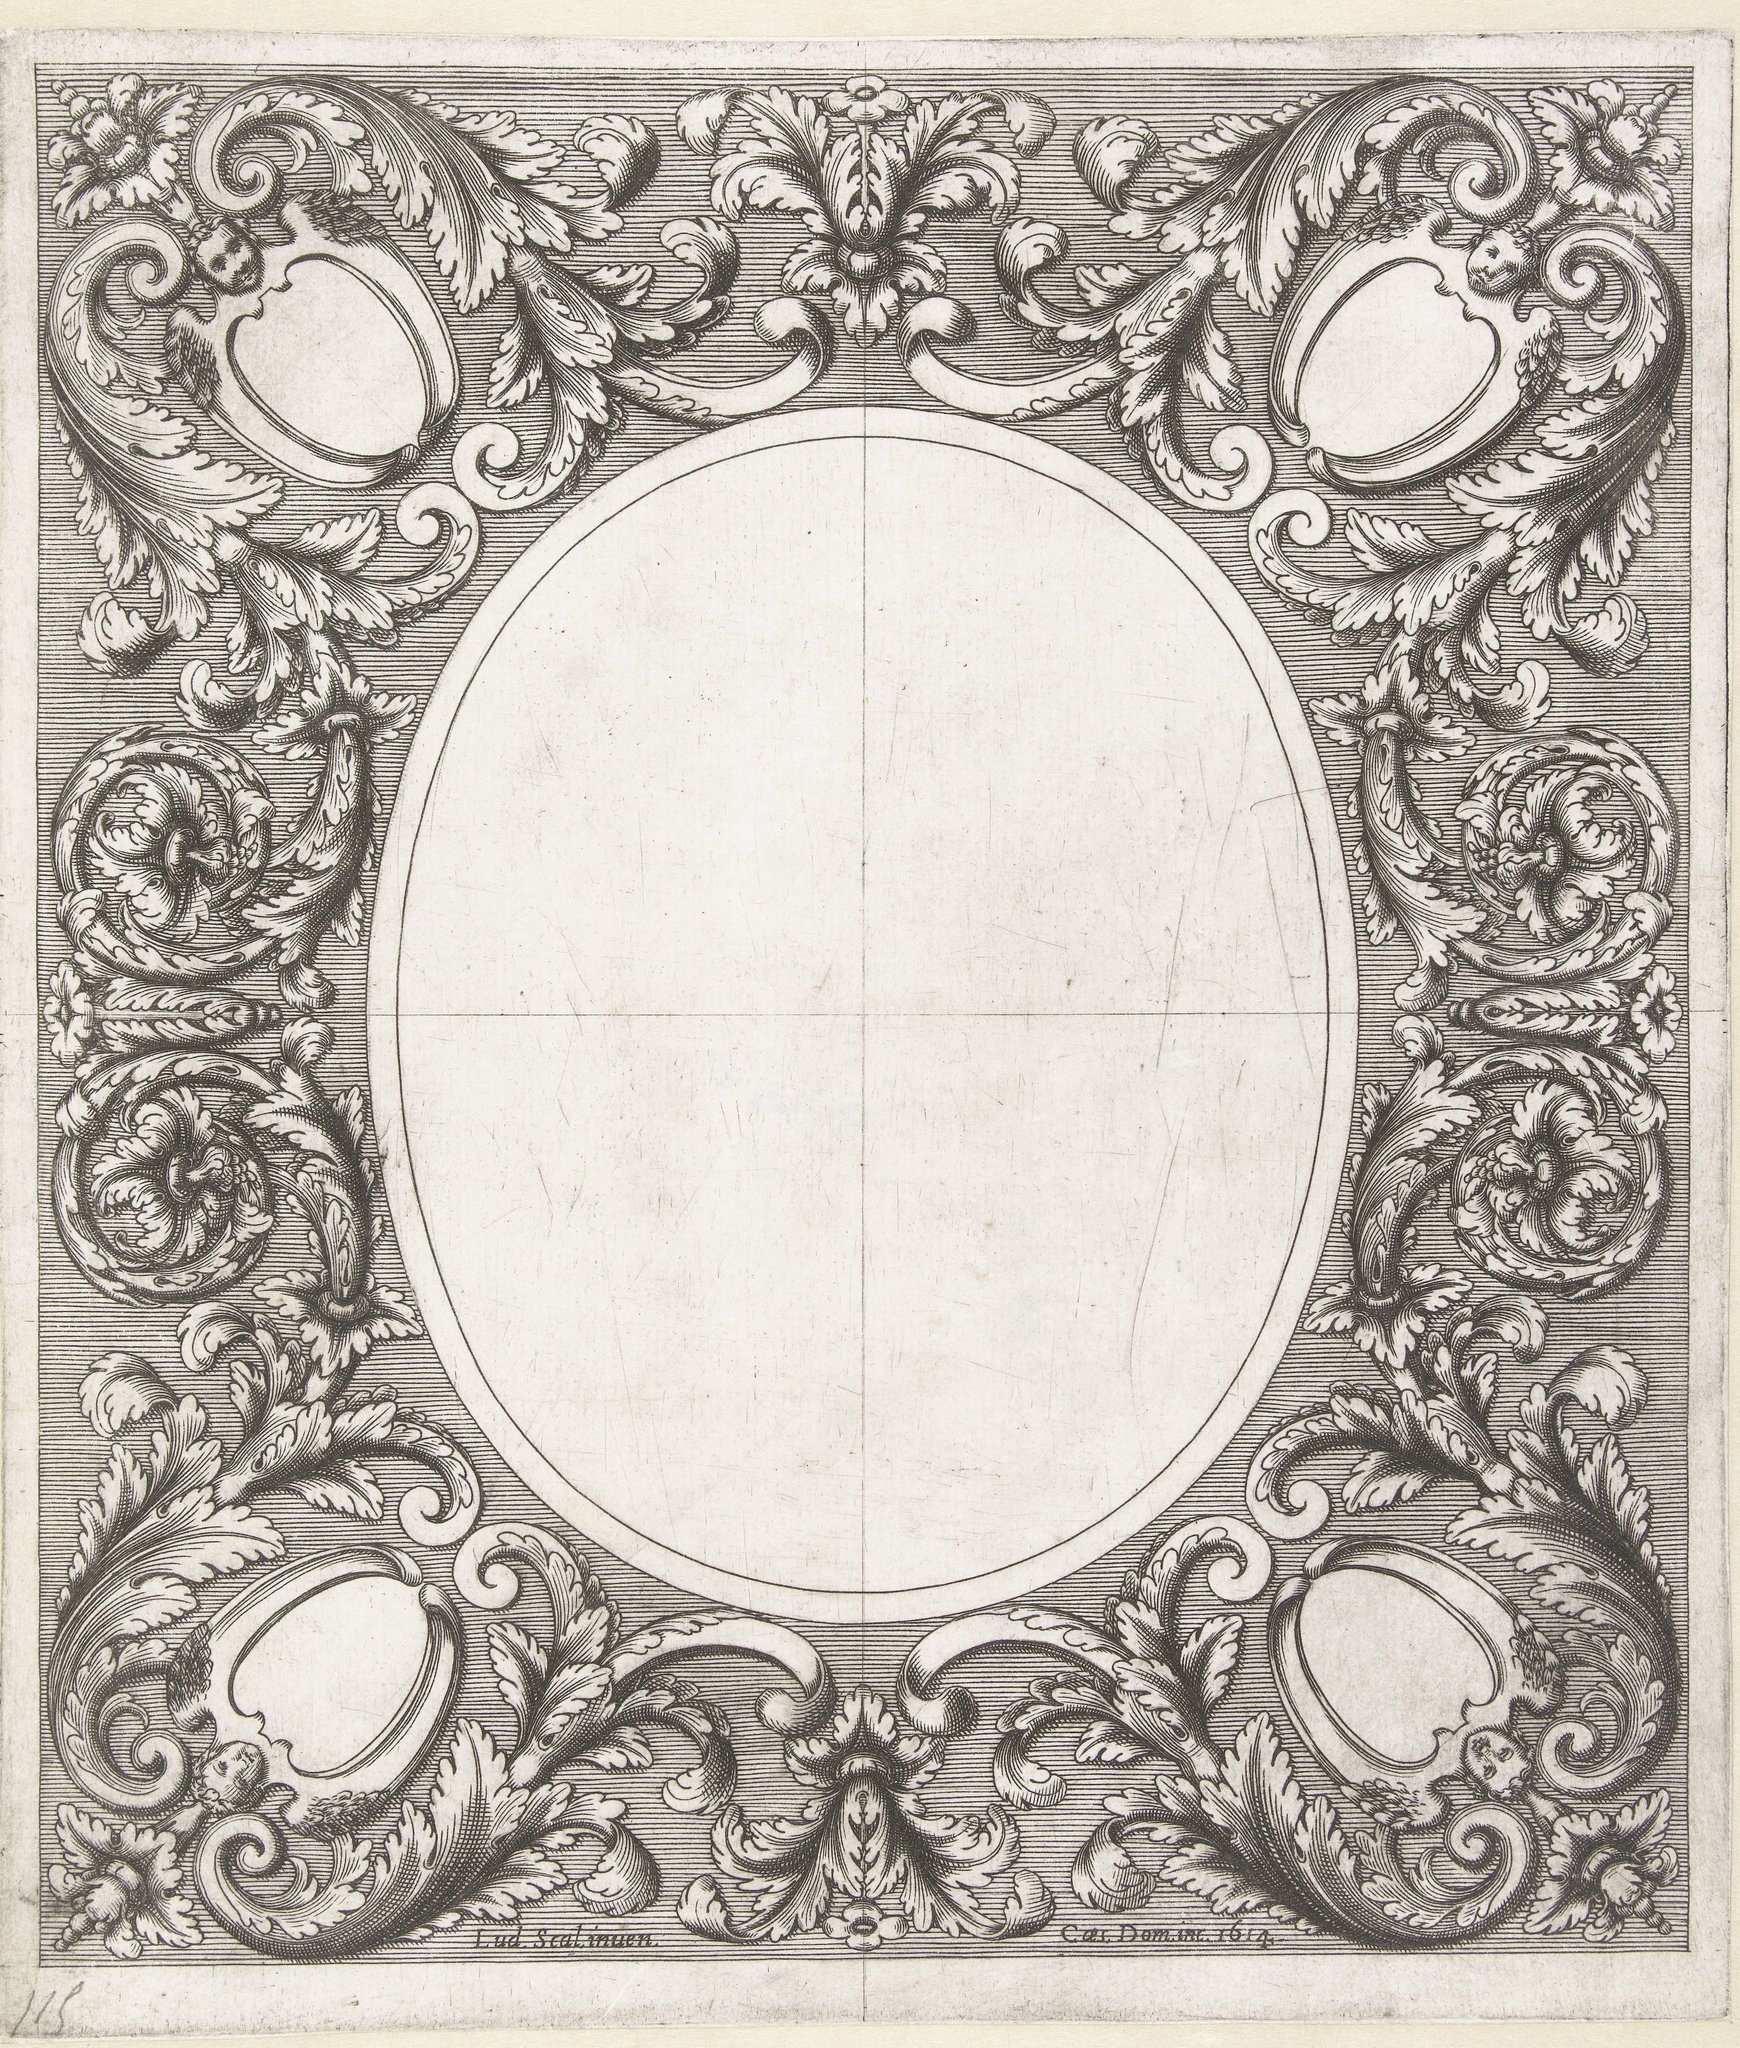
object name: print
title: Plafonddecoratie met in het midden een leeg ovaal veld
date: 1614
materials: paper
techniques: engraving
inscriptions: date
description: Het ovaal is omlijst door voluten van bladranken op een horizontaal gearceerde achtergrond. In de vier hoeken hangt een cartouche bekroond door een mascaron met een bladerentoef op het hoofd.